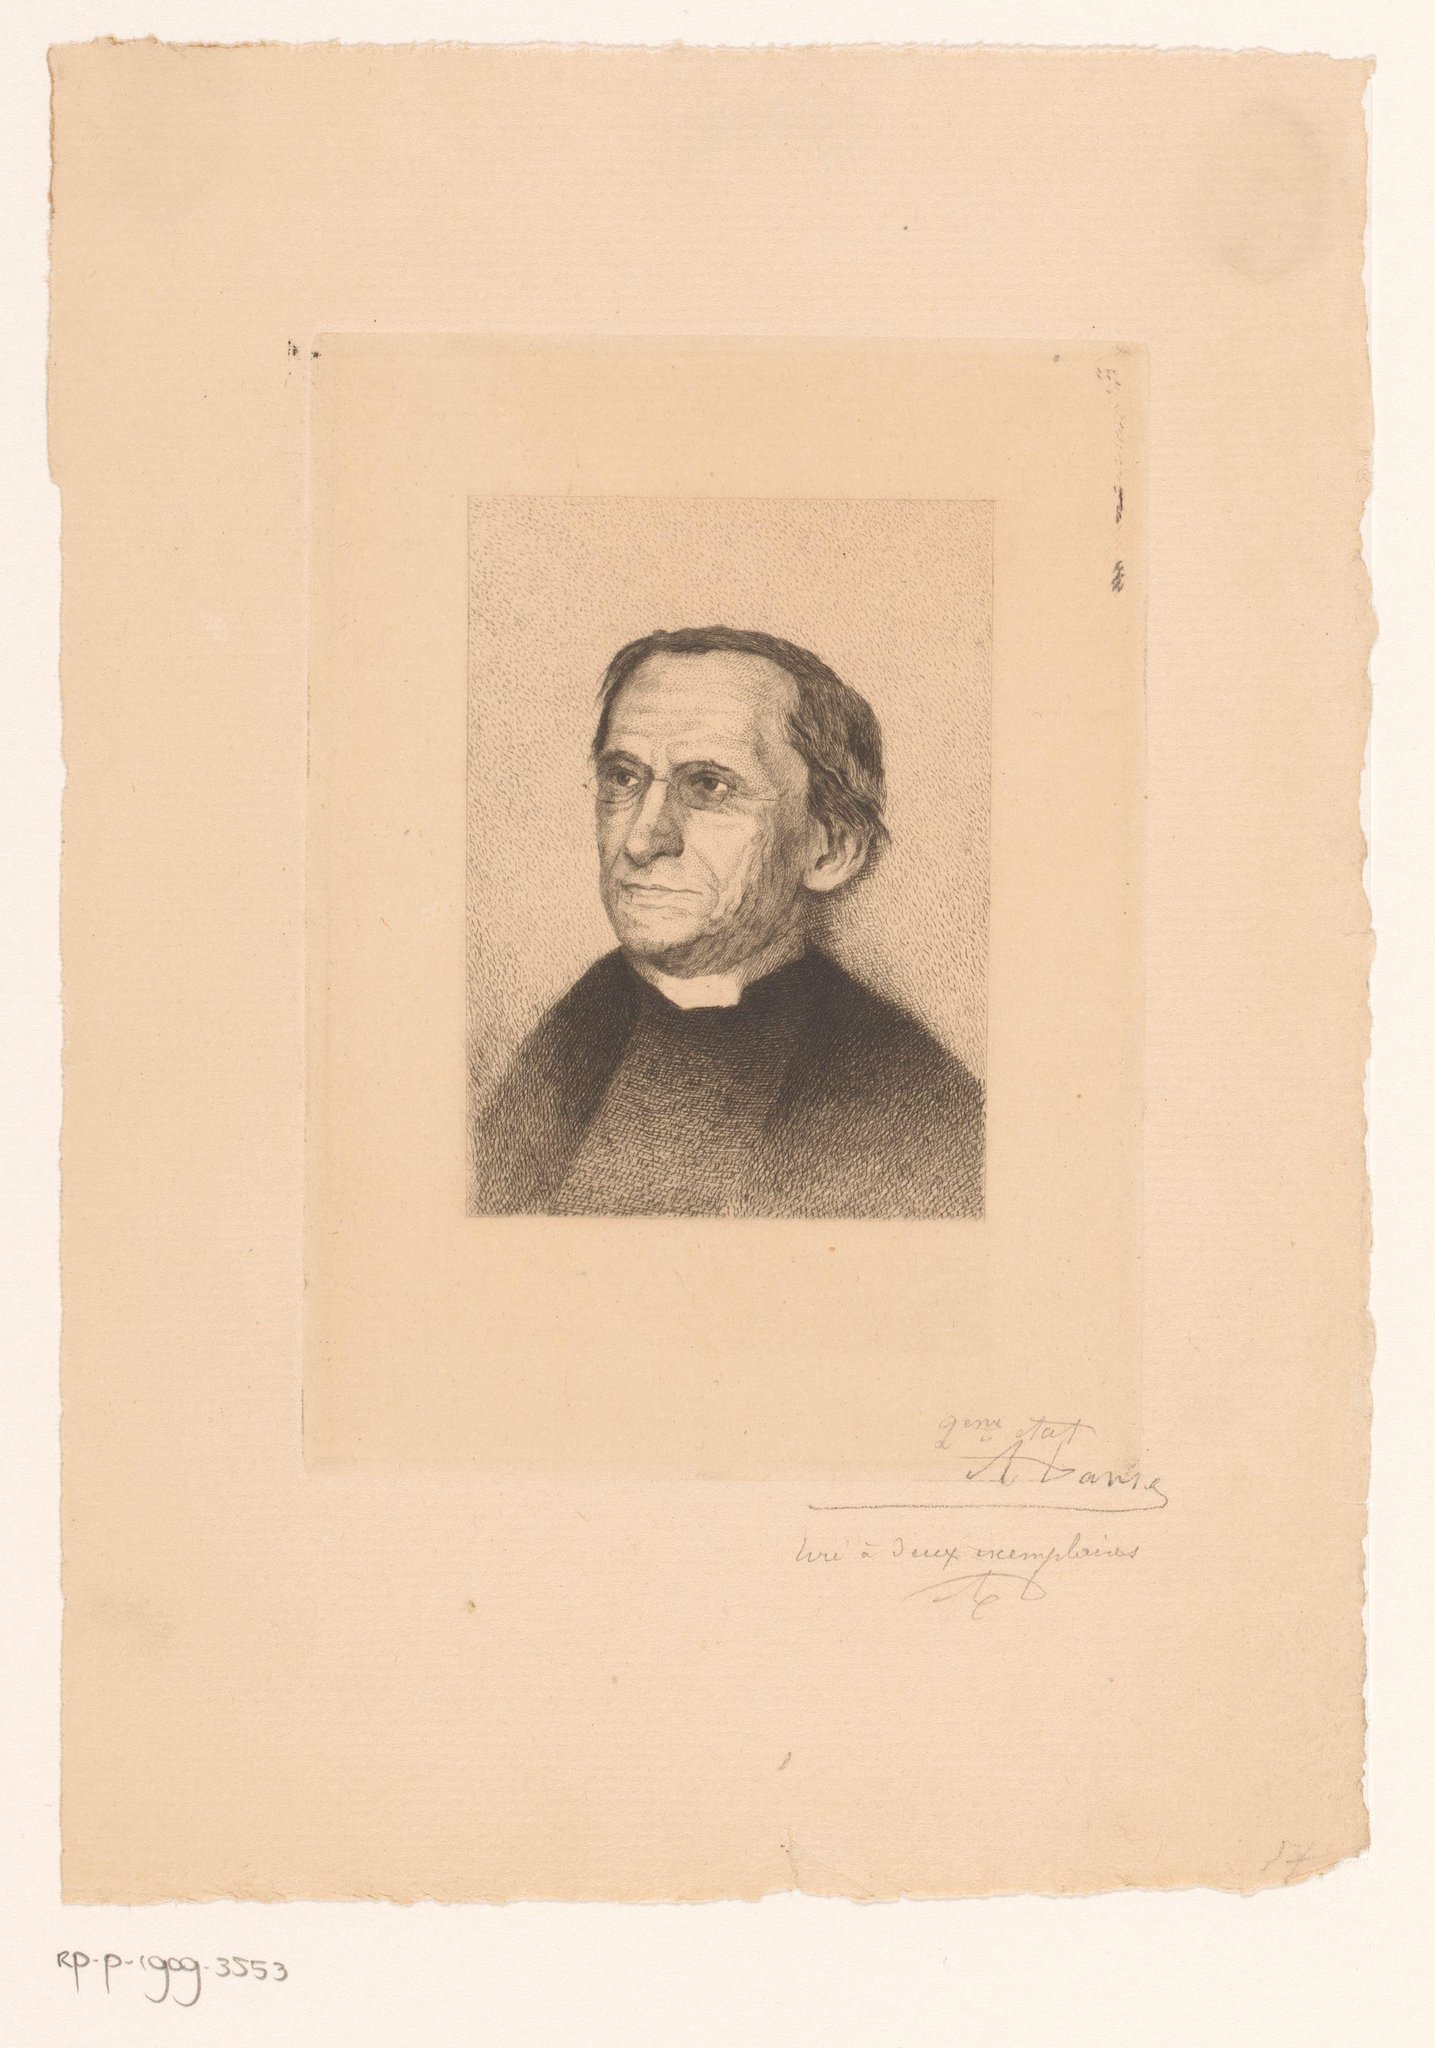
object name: print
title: Portret van Charles de Harlez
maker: auguste danse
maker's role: print maker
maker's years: 1829-1929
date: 1895-1896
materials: paper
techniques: etching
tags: liège, priest, historical person (...) - historical person (...) portrayed alone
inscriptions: collector's mark: Lugt 2228, annotation: ‘3eme etat; tire á deux exemplaires’